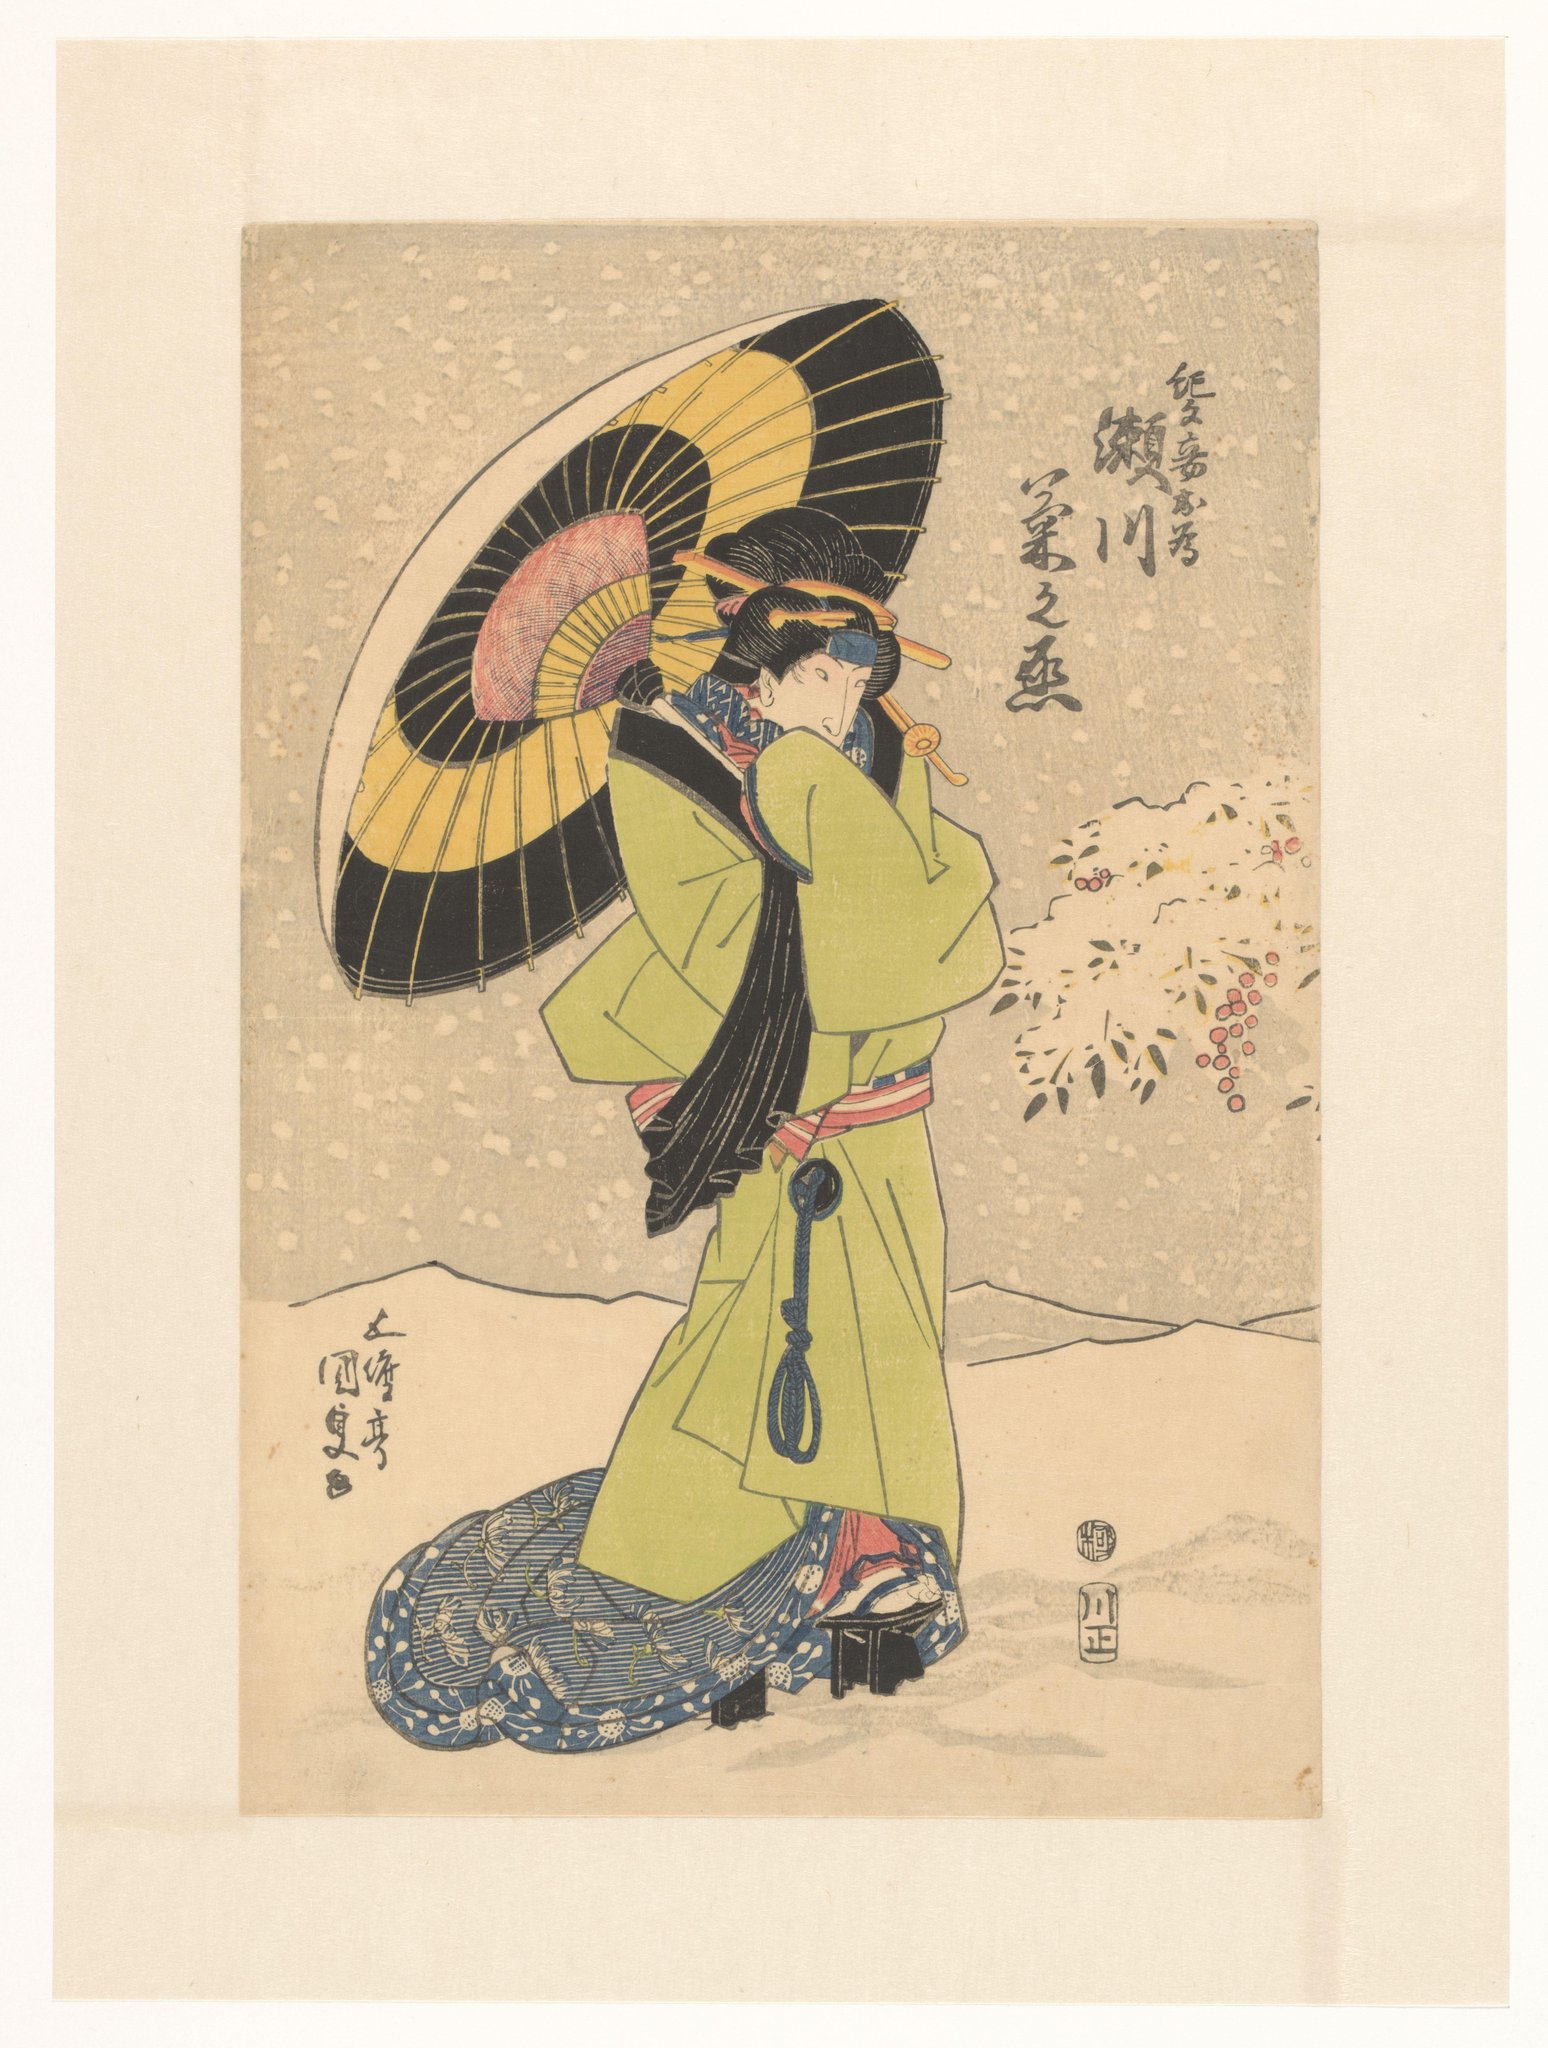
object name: print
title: Concubine Mekame in snow with umbrella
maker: utagawa kunisada (i)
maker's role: print maker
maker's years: 1786-1865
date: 1830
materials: paper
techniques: woodcut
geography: japan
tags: concubine, umbrella, snow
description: Kabuki acteur Segawa Kikunojô V in de rol van concubine Otame, onder een paraplu, in de sneeuw.